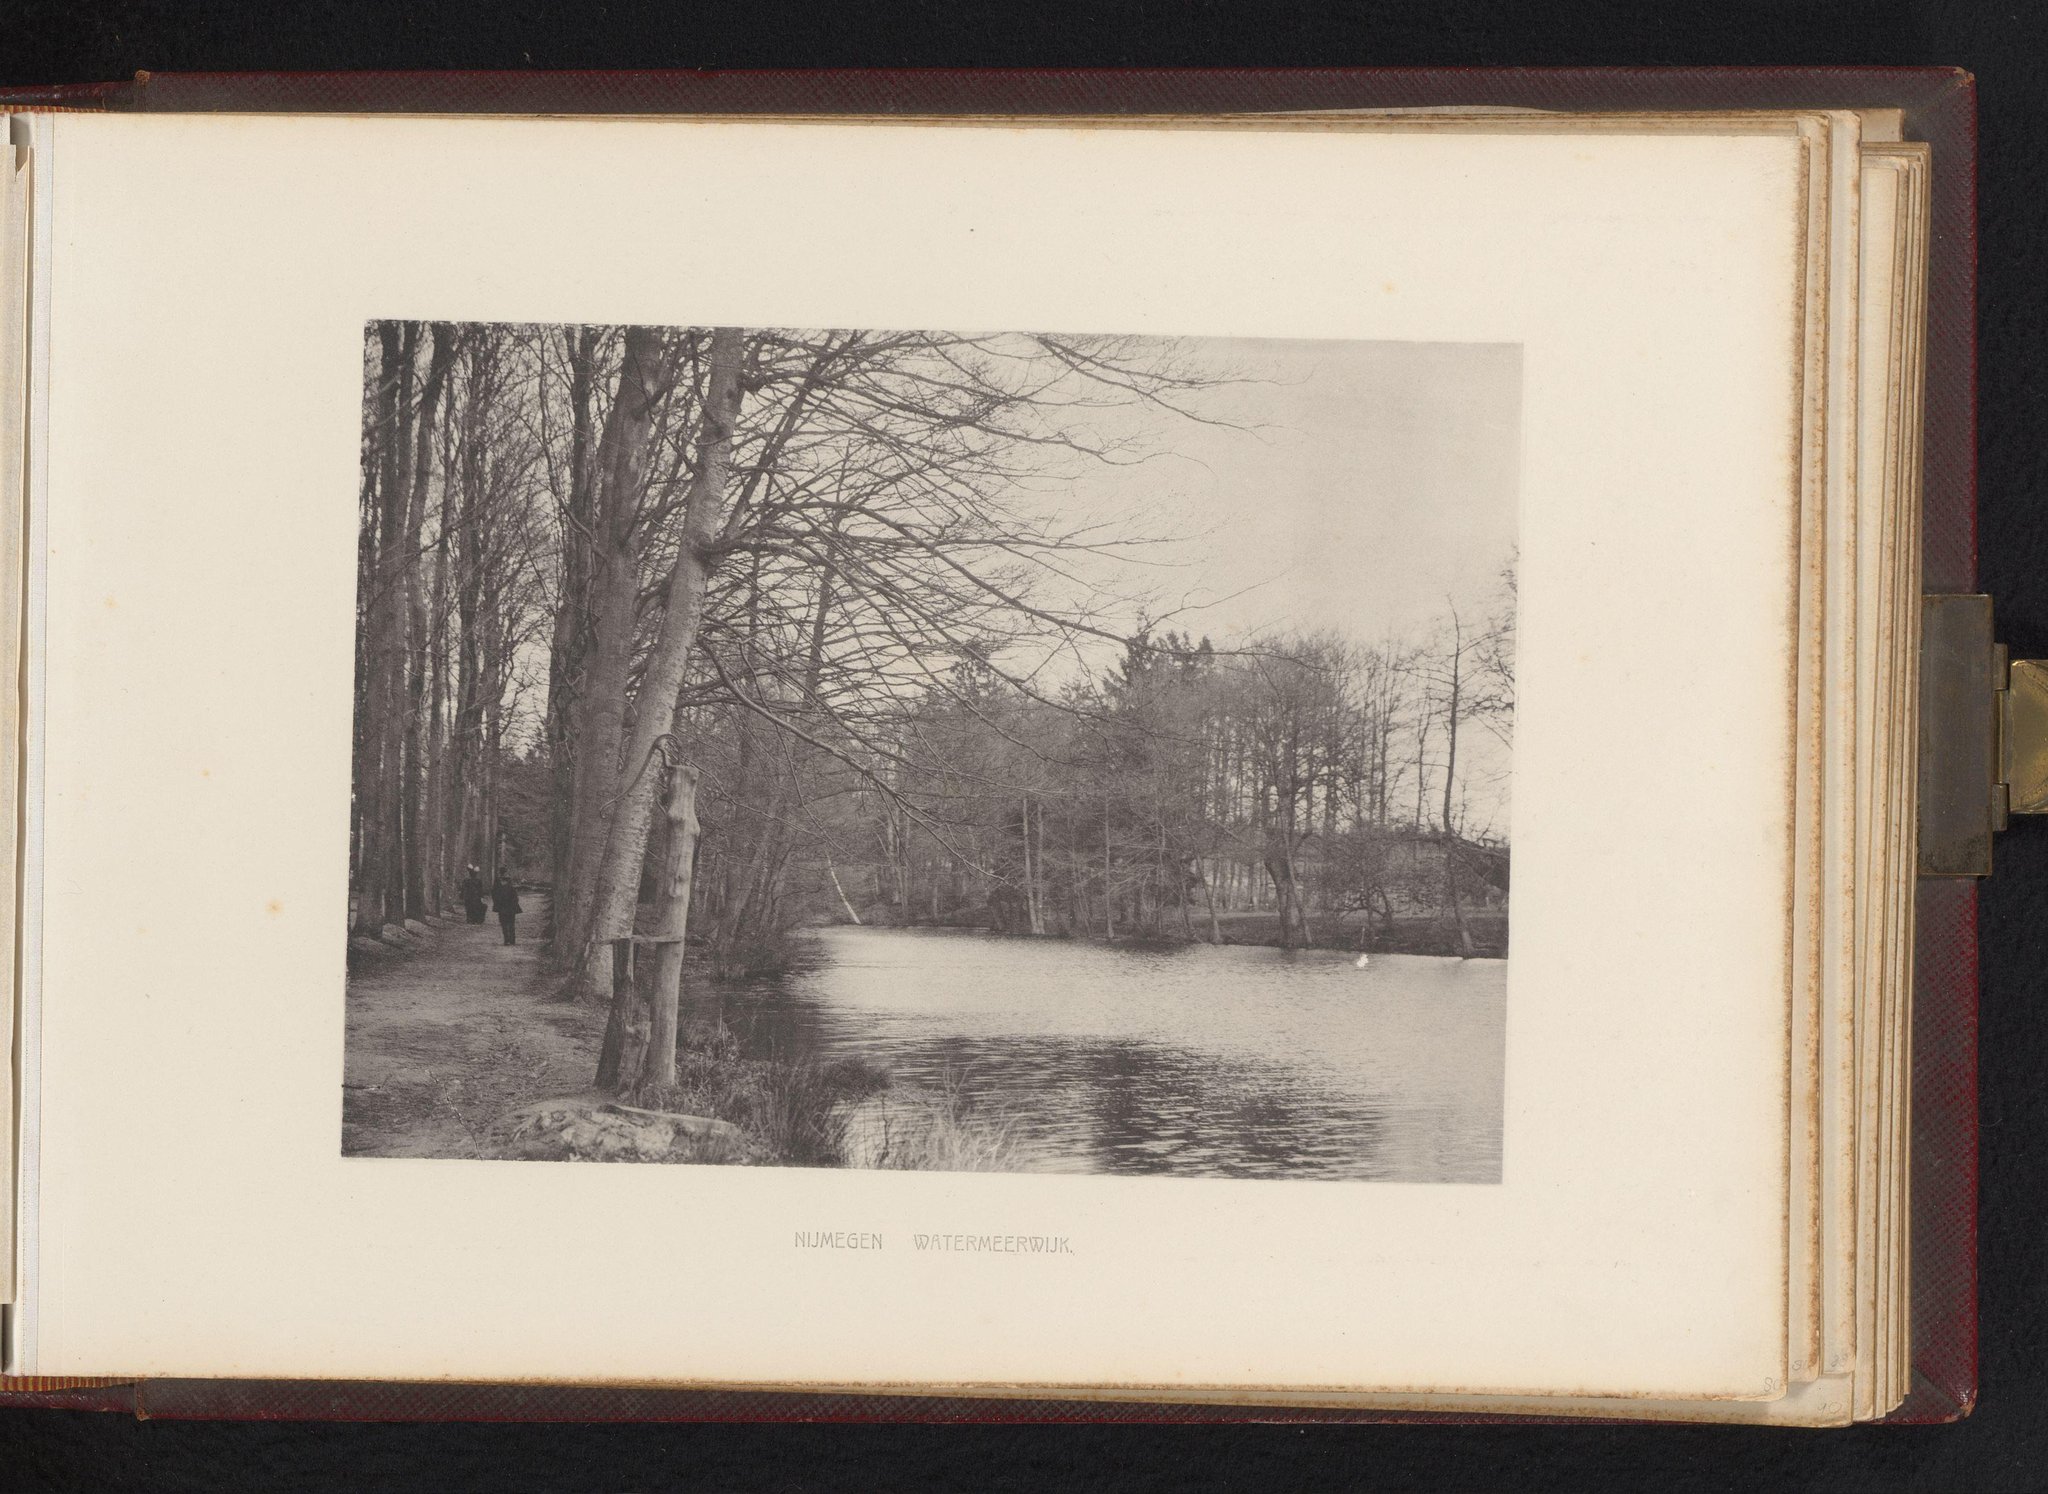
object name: album leaf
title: Landgoed Watermeerwijk te Nijmegen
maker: Anonymous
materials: paper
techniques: photograph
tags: trees, landscapes with waters, waterscapes, seascapes (in the temperate zone), nijmegen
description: Deze pagina maakt deel uit van een album.